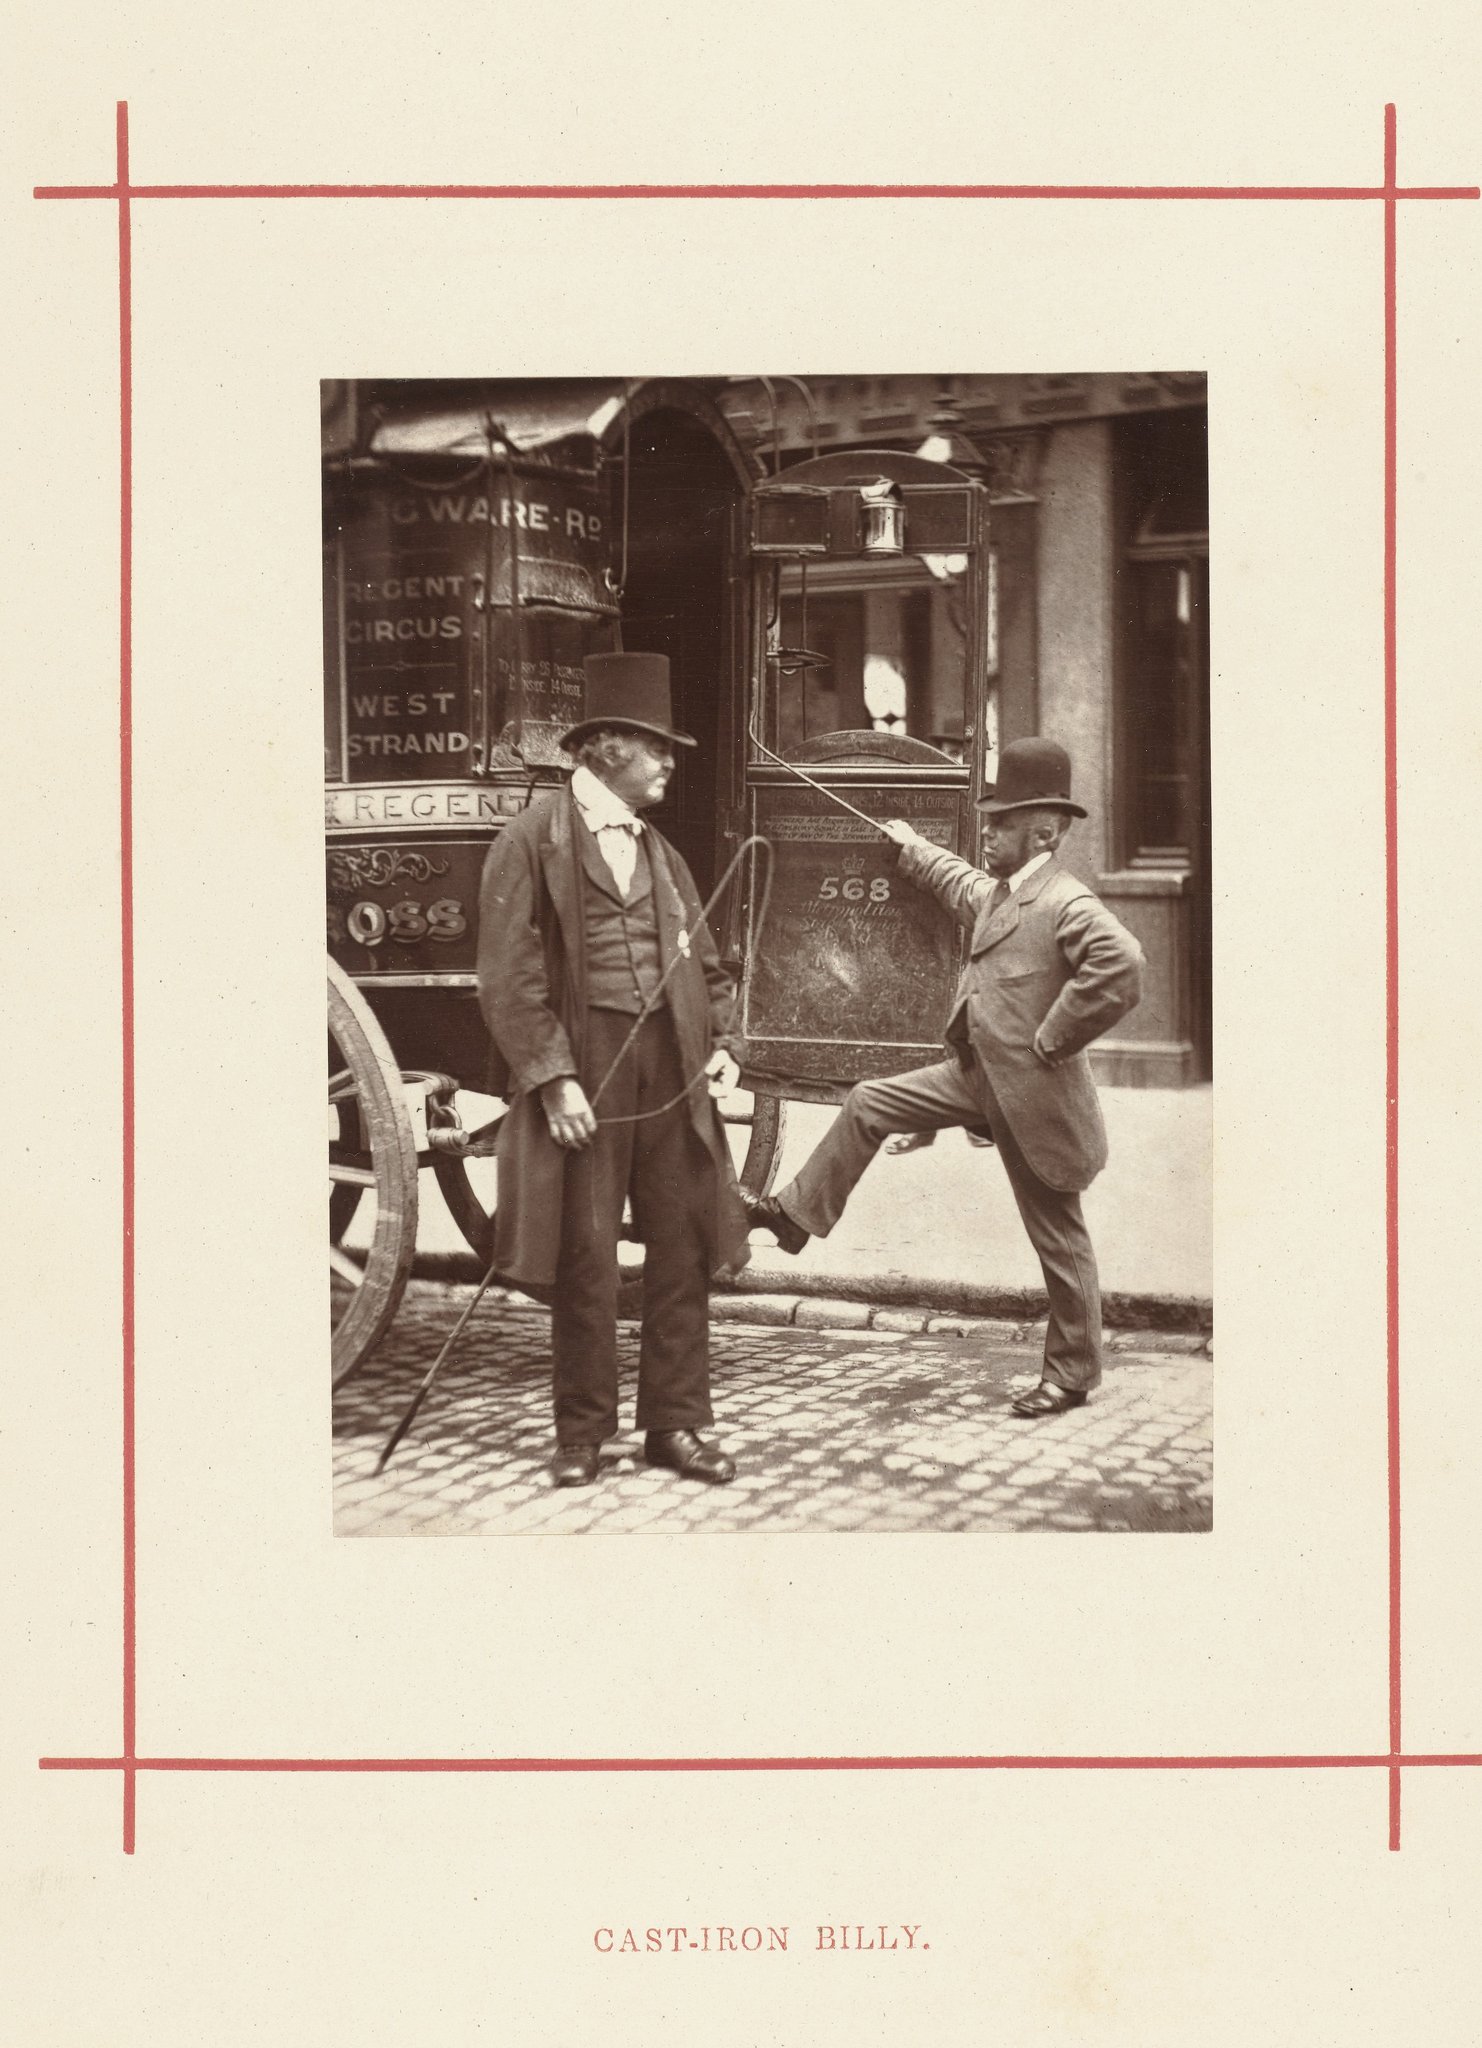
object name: photomechanical print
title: Koetsier met passagier in Londen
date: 1876-1877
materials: cardboard, paper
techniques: woodburytype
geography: england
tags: passenger carriage, london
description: Plaat uit dit boek J. Thomson en Adolphe Smith, Street Life in London, Part 8 (1st September, 1877).